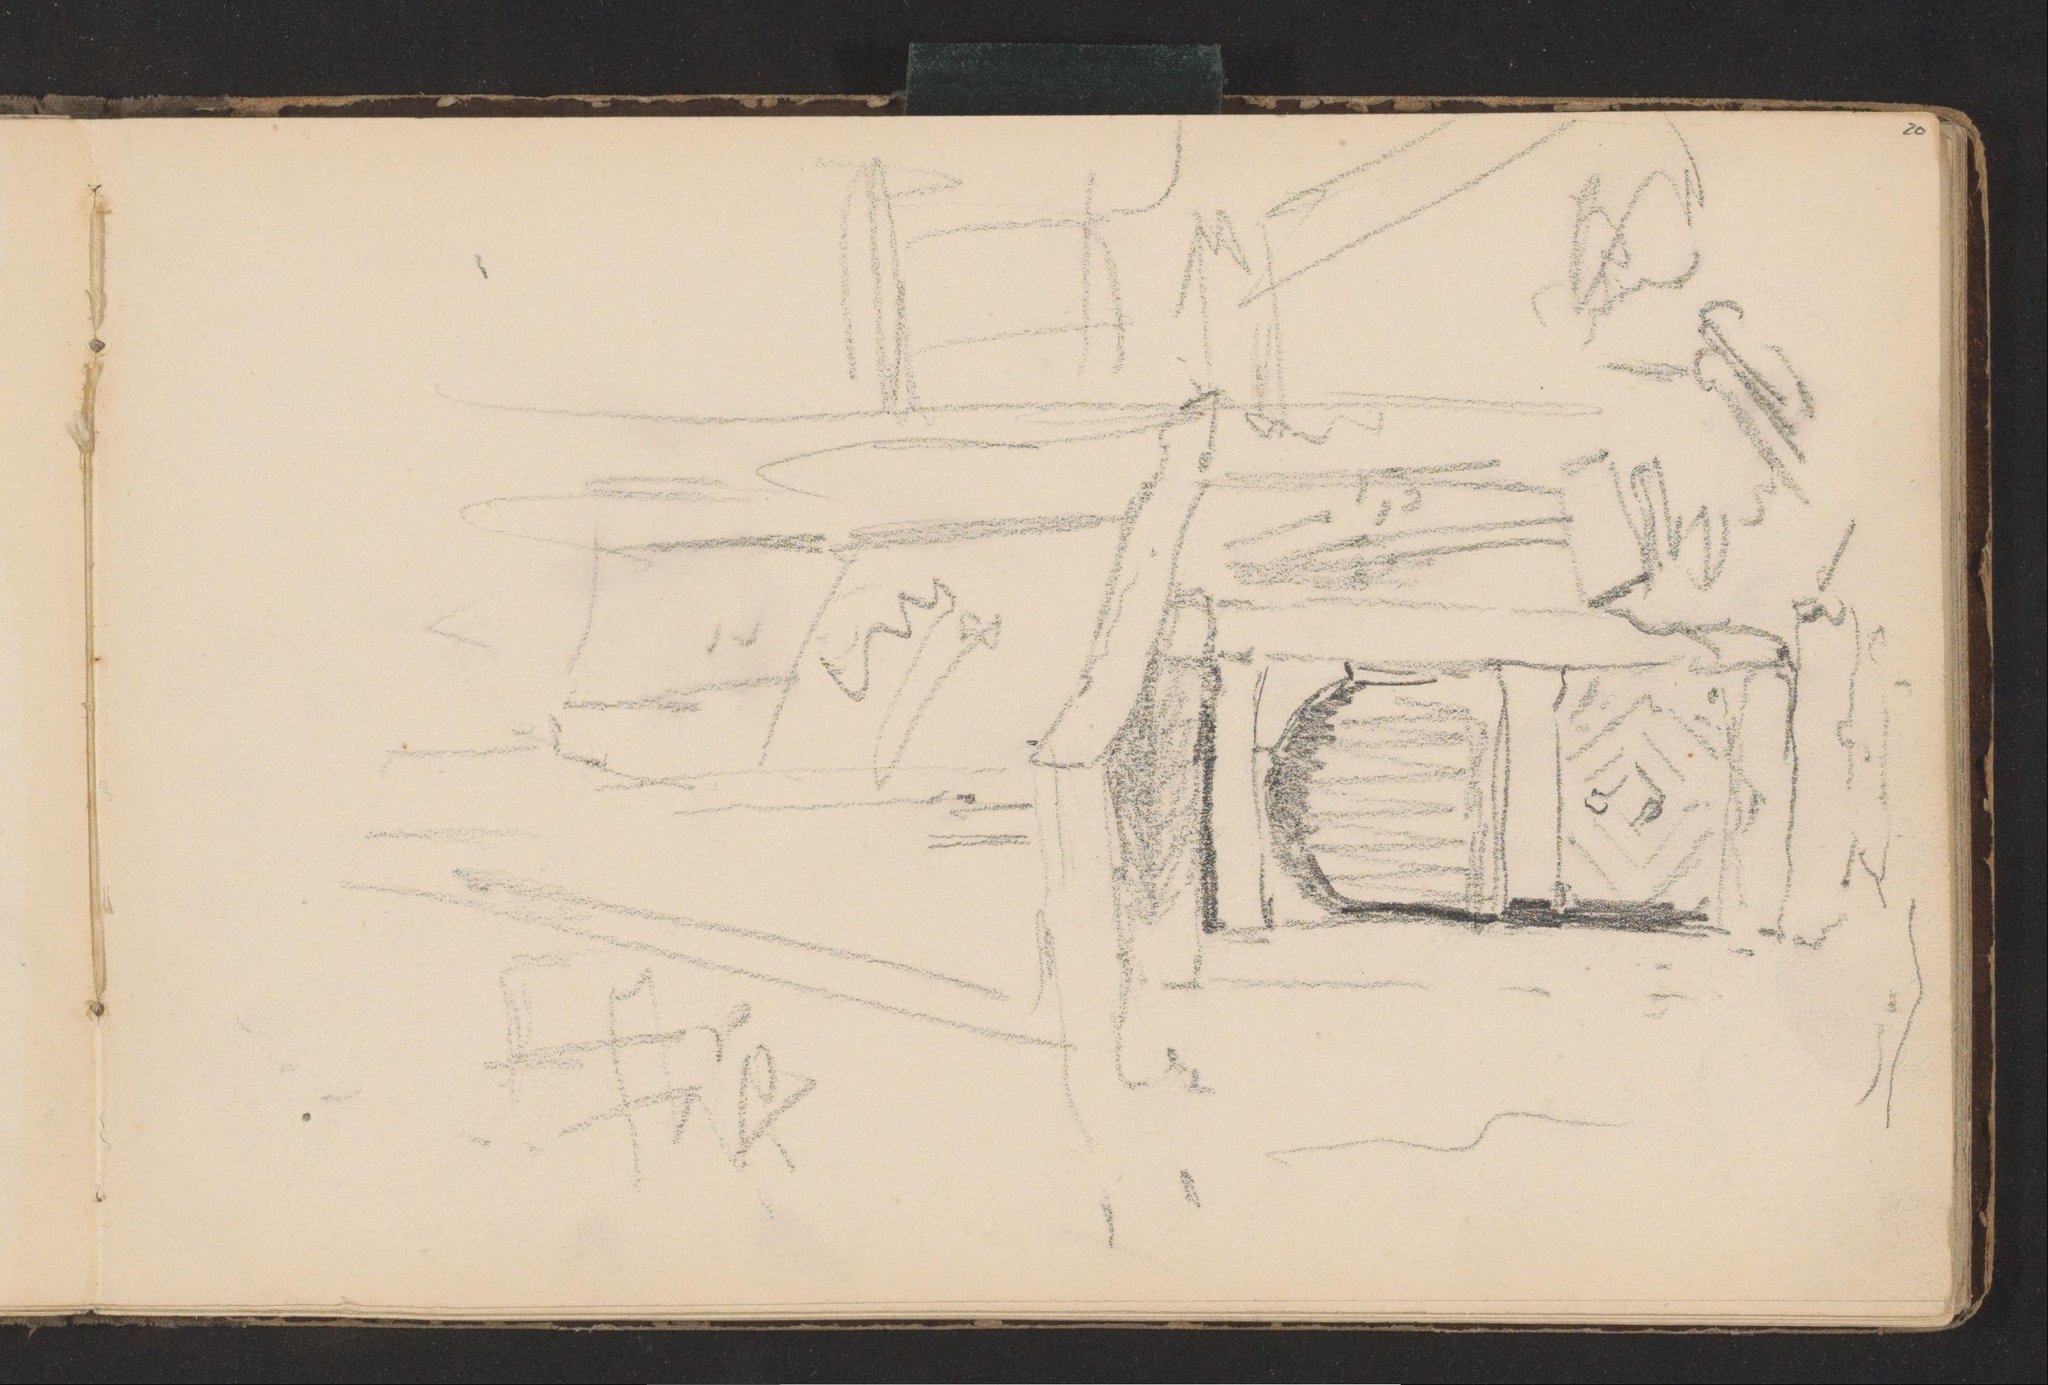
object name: sketchbook leaf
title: Voordeur van een huis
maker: maria vos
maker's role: draughtsman, painter, print maker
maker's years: 1824-1906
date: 1871-1878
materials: paper, pencil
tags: front façade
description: Blad 20 recto uit een schetsboek met 45 bladen.